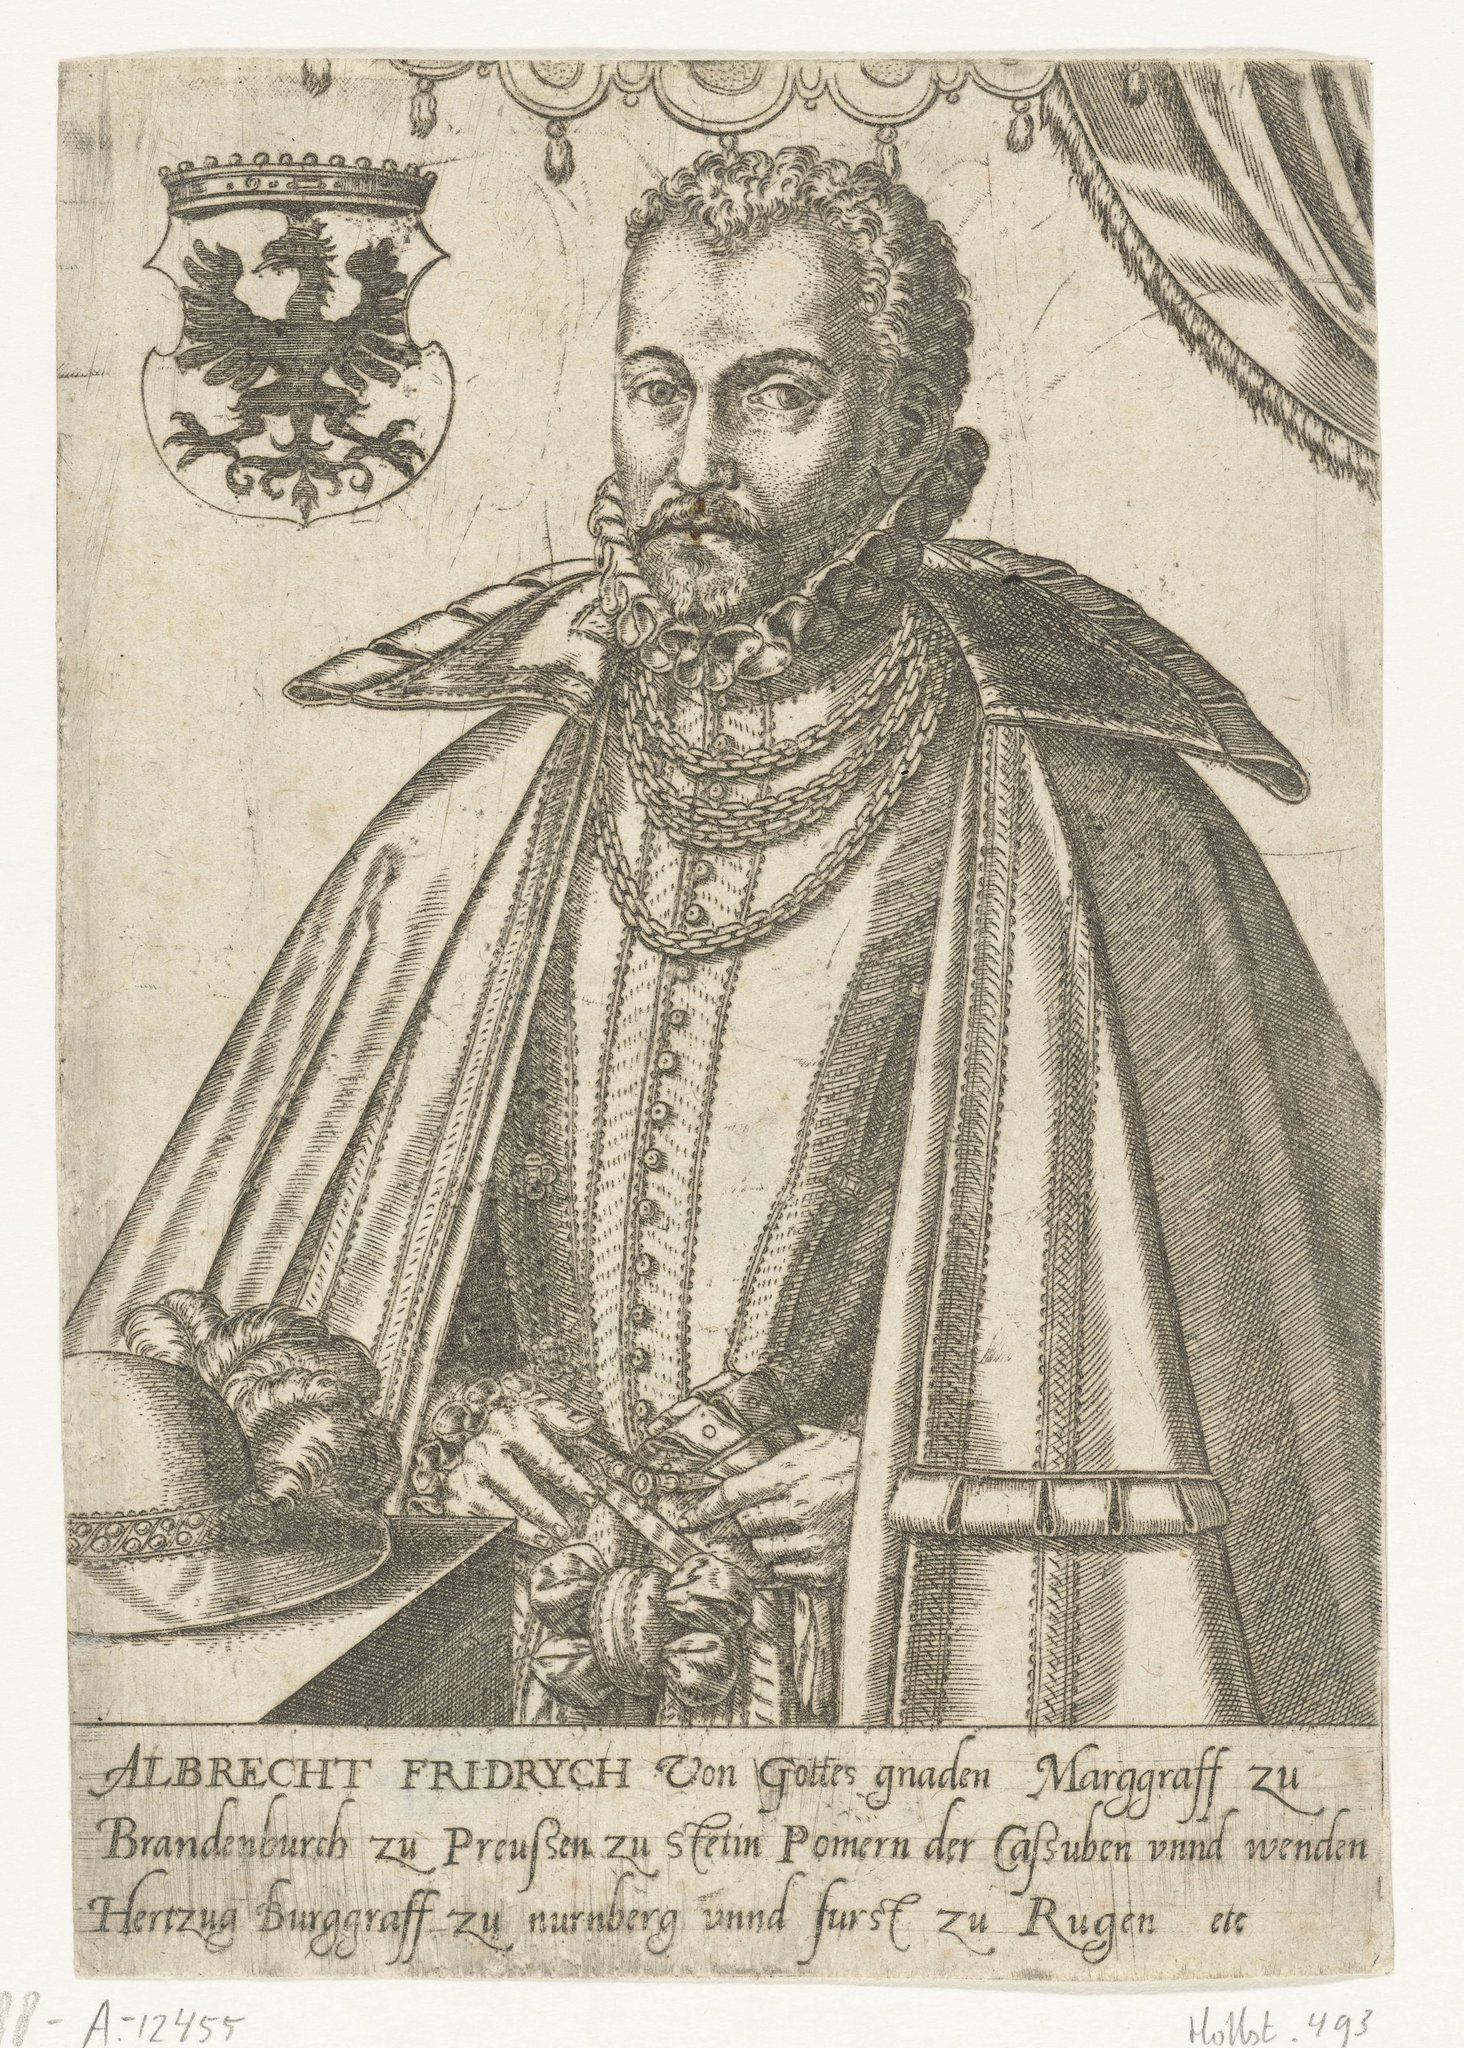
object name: print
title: Portret van Albrecht Friedrich, Markgraaf van Brandenburg.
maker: abraham de bruyn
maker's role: print maker, publisher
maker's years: 1540-1587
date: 1550-1587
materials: paper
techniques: engraving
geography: antwerp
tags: cape (+ men's clothes), codpiece (cover for the genitals), historical persons, head-gear: hat (+ men's clothes), neck-gear: collar (+ men's clothes), gloves, mittens, etc. (+ men's clothes), necklace (+ men's clothes)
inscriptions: collector's mark: Lugt 2228, caption: ‘Albrecht Friedrich von Gottes Gnaden Marggraf zu Brandenburch zu Preussen, zu Stetin Pomern der Cassulben und Wenden/ Hertzug Burggraff zu Nurnberg und furst zu Rugen etc.’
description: Kleding: Cape met uitstaande brede platte kraag. Geplooide lubbenkraag, opstaand tot oren. Vierdubbele ketting om de hals. Codpiece met strik. Handschoenen in de linkerhand. De hoed met ronde hoge bol en platte rand met pluimen ligt op tafel.